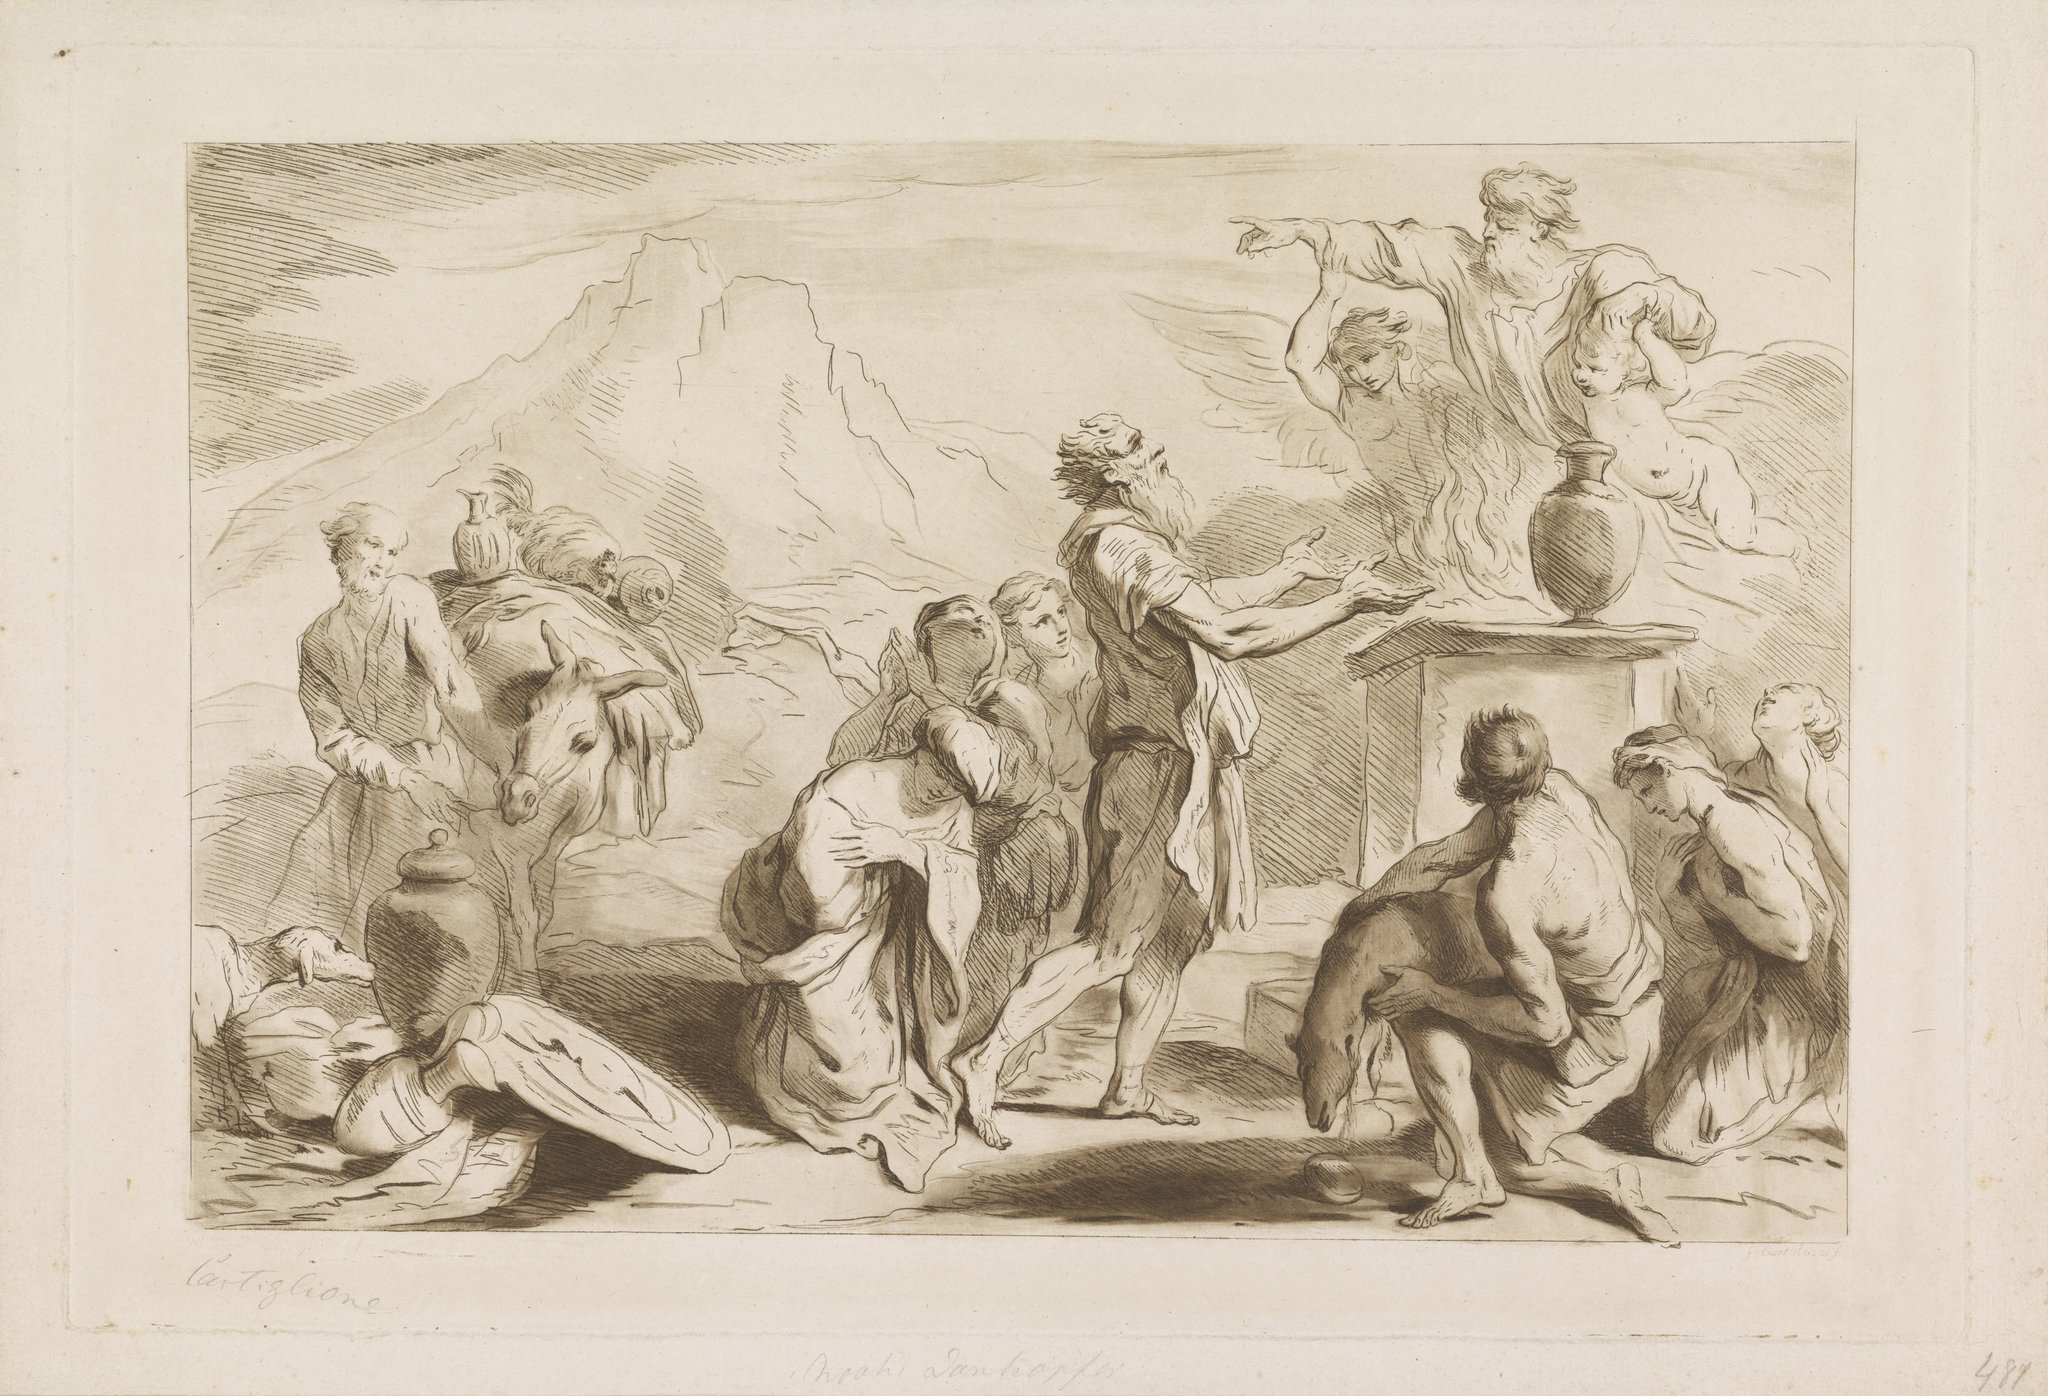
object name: print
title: Offer van Noach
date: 1738-1815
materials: paper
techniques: etching, intaglio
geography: italy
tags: noah's sacrifice; various animals are offered, possibly a lamb, a dove and a ram (often combined with the rainbow of the covenant)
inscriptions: collector's mark: Lugt 2228, number: ‘2917’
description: Noach staat met uitgestrekte armen voor een altaar, waarboven God en twee engelen zijn verschenen. Andere figuren zitten rond het altaar geknield. Links een man met een ezel, een hond en een kip.